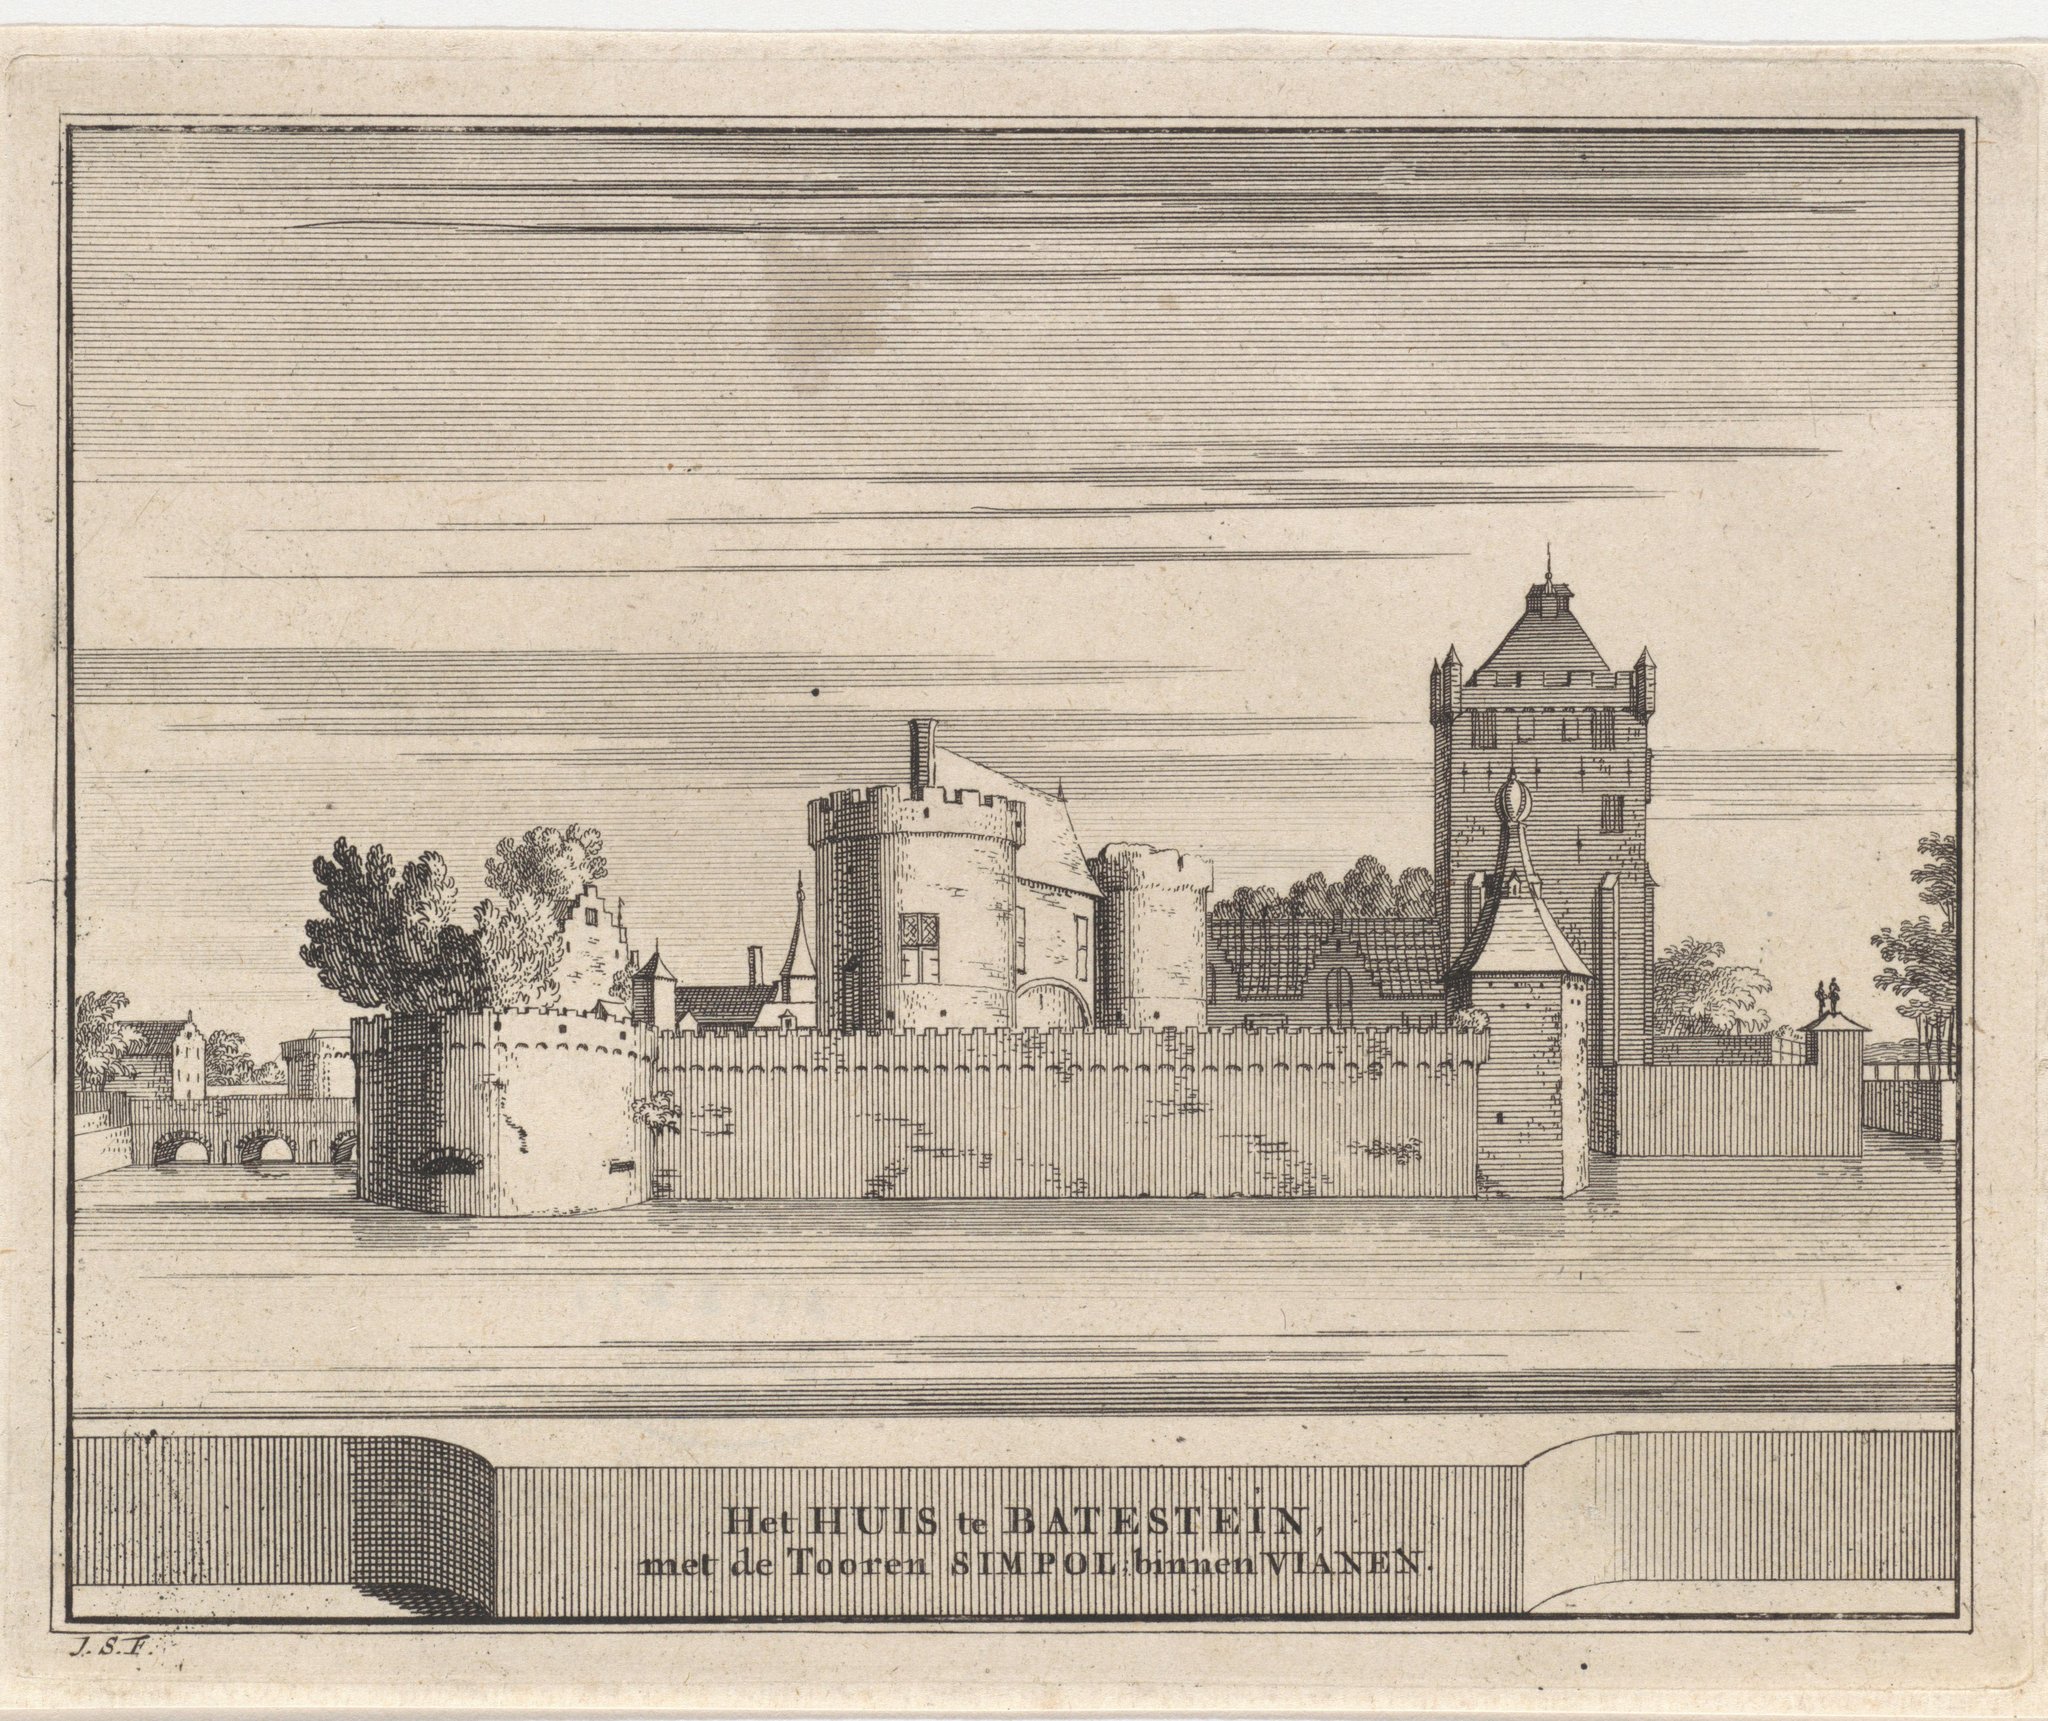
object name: print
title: Het Huis te Batestein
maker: jacobus schijnvoet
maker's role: draughtsman, print maker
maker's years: 1685-1743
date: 1711-1774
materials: paper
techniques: etching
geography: amsterdam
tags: castle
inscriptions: collector's mark: Lugt 2228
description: Prent als illustratie opgenomen in: Smids, Ludolph. Schatkamer der Nederlandsse[!] oudheden; of Woordenboek, behelsende Nederlands steden, Amsterdam: Pieter de Coup, 1711. Verscheen tevens in de heruitgave van voorgenoemd werk in 1737 en 1774. In 1721 verscheen er een uitgave met alleen de prenten: Nederlandsche oudheden, bestaande in zestig verbeeldingen (...) gelegen in Holland, 't Sticht van Utrecht en Gelderland enz. Amsterdam: Hendrik Bosch, 1721.